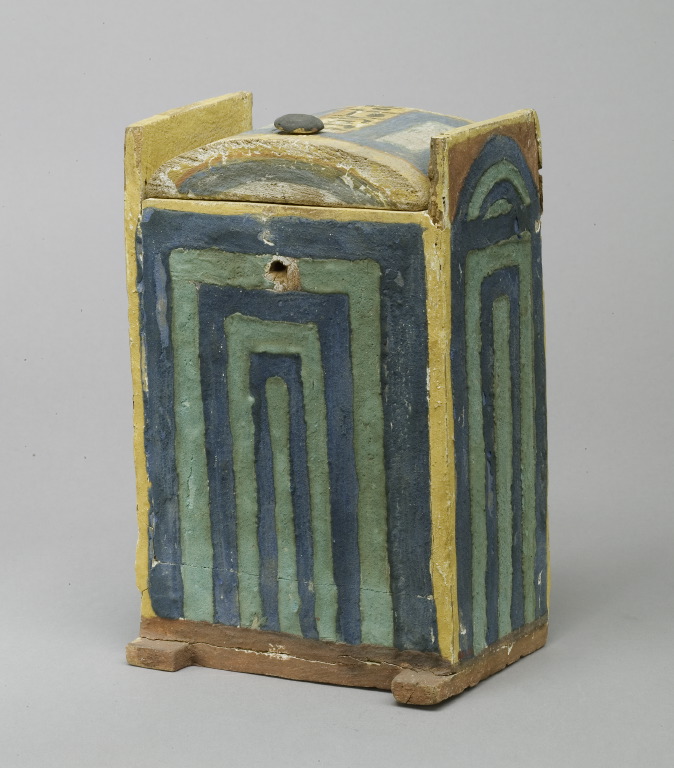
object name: shabti box, khabekhnet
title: Shabti box of Khabekhnet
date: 1279-1213 BCE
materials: gesso, paint, wood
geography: egypt